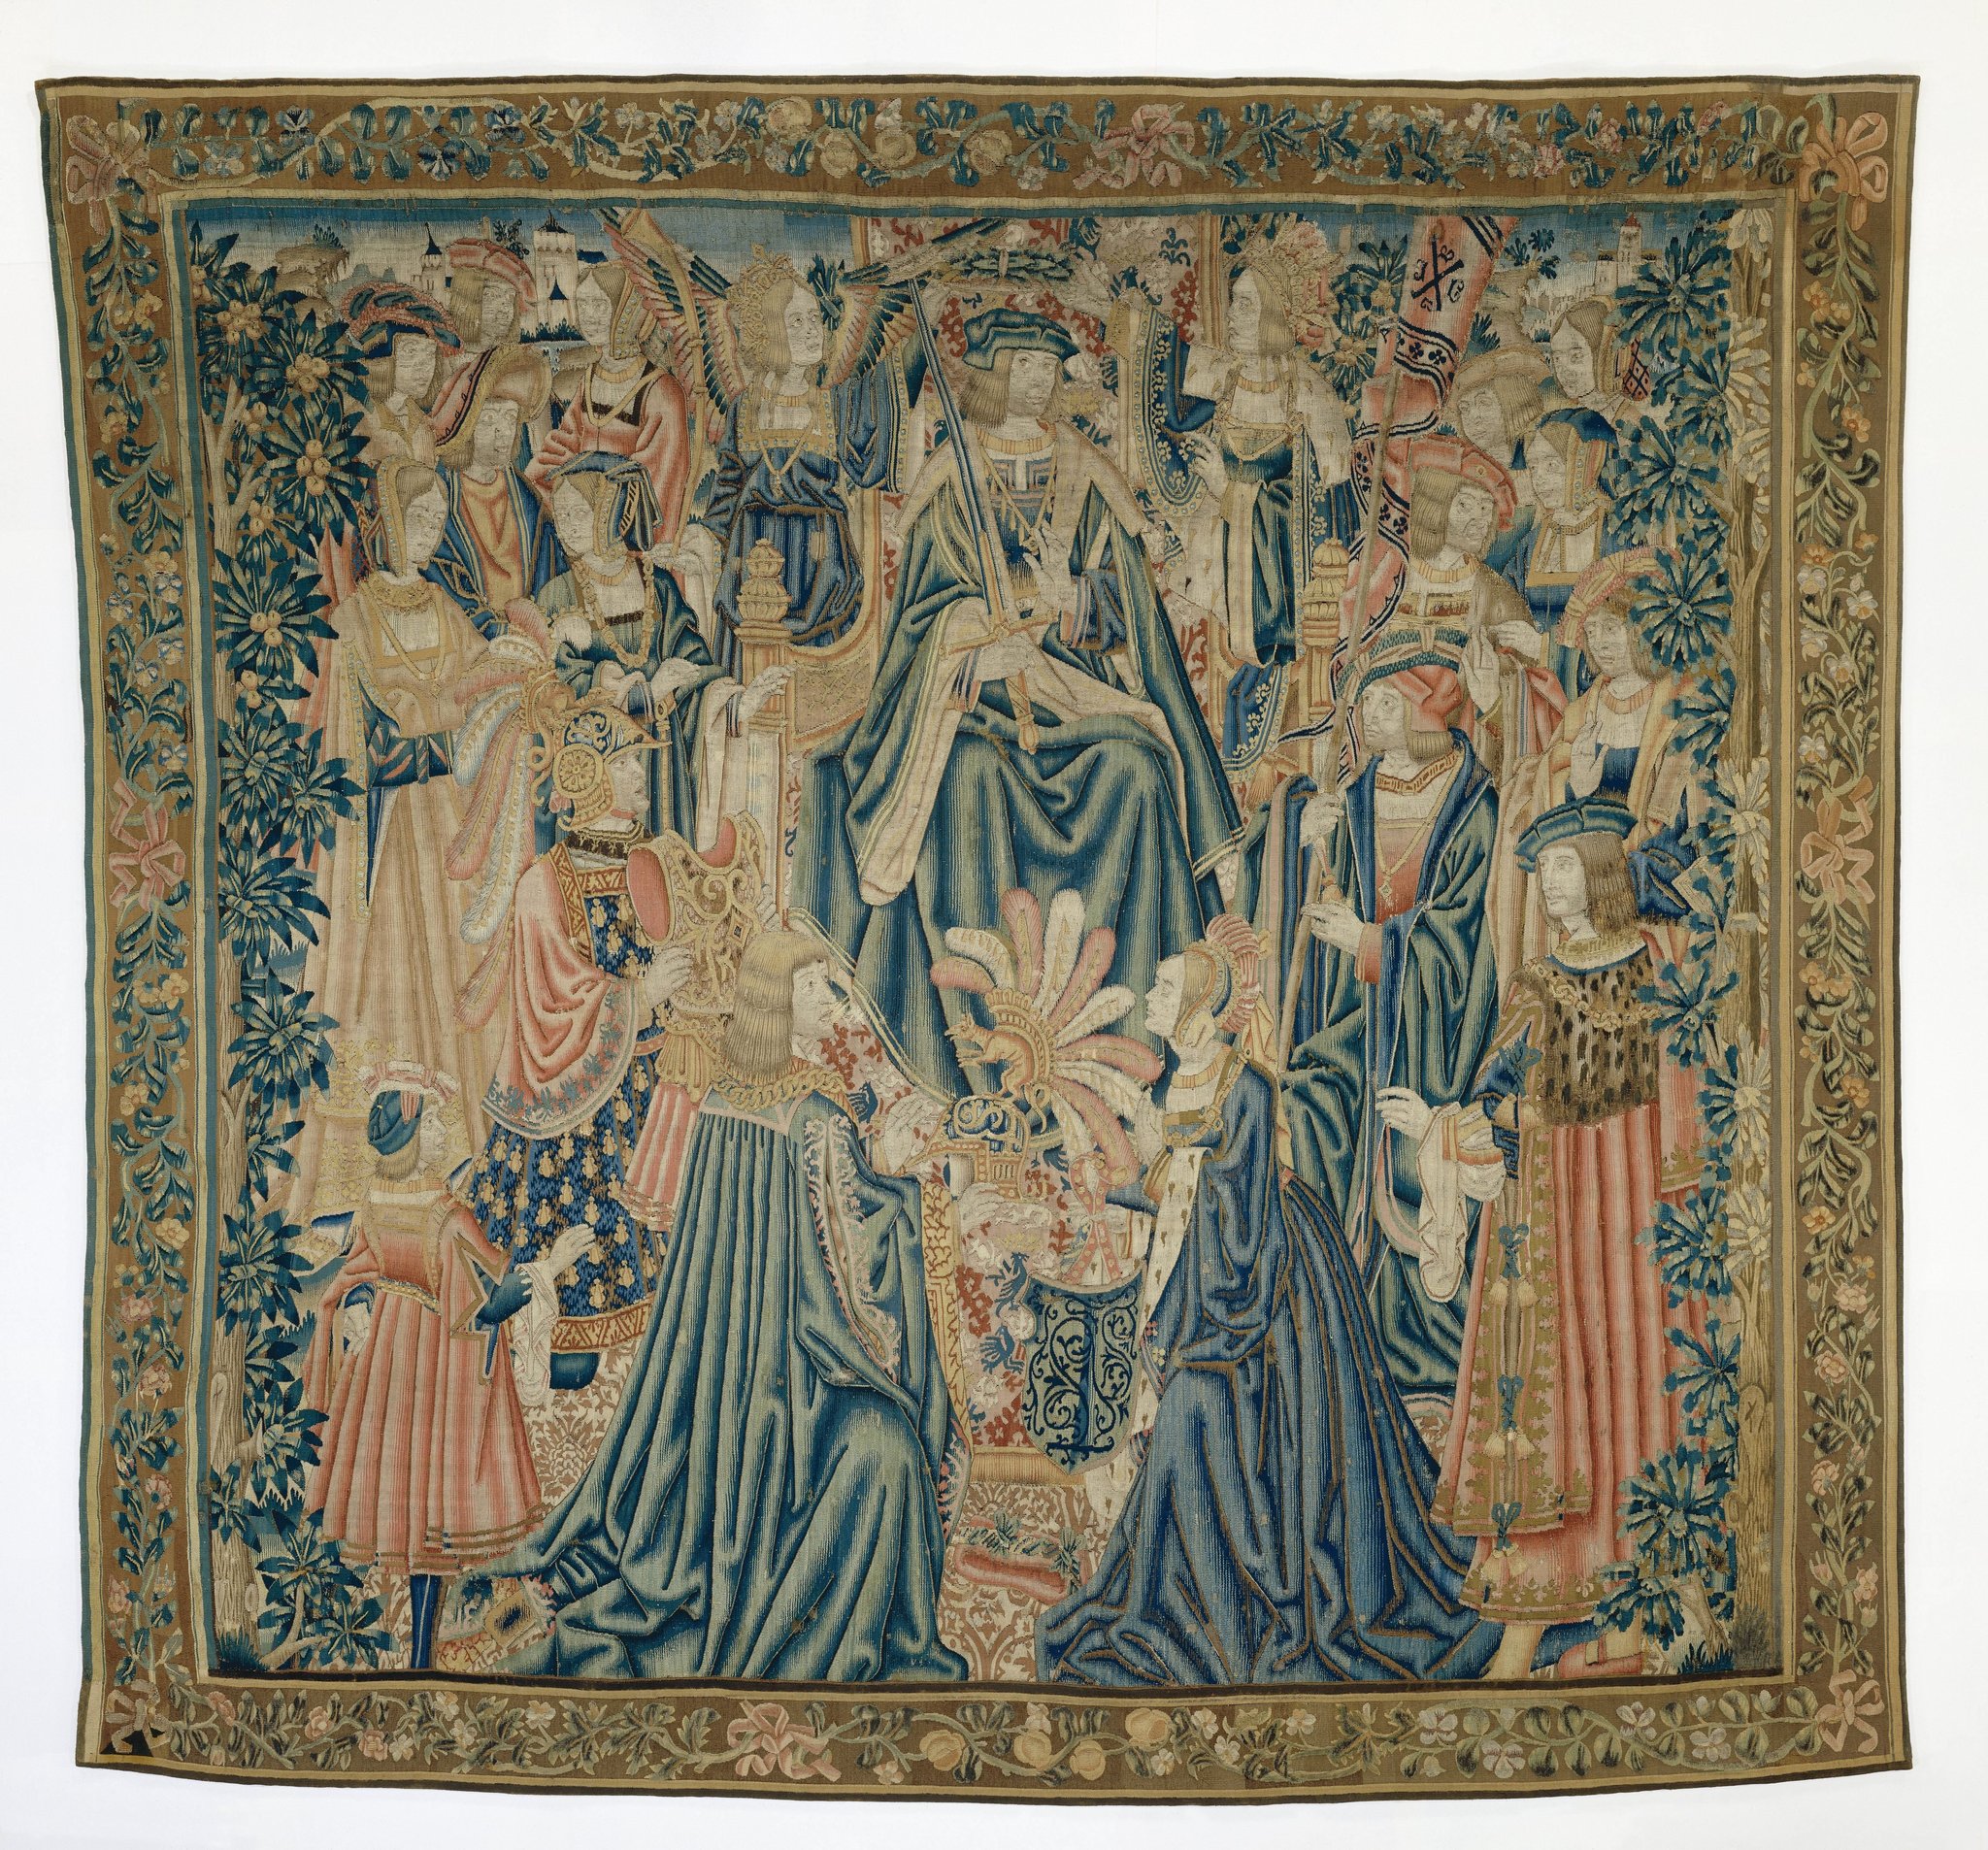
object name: tapestry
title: Hofscène met een vorst die de insignia ontvangt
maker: Anonymous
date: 1500-1525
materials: wool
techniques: tapestry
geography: southern netherlands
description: Tapestry.The Installation of Philip the Fairas Defender of the Land. Wool, silk. Southern Netherlands, c. 1520. The scene relates to Philip the Fair's Joyous Entry in 1494, when he attained his majority and was sworn in as ruler.